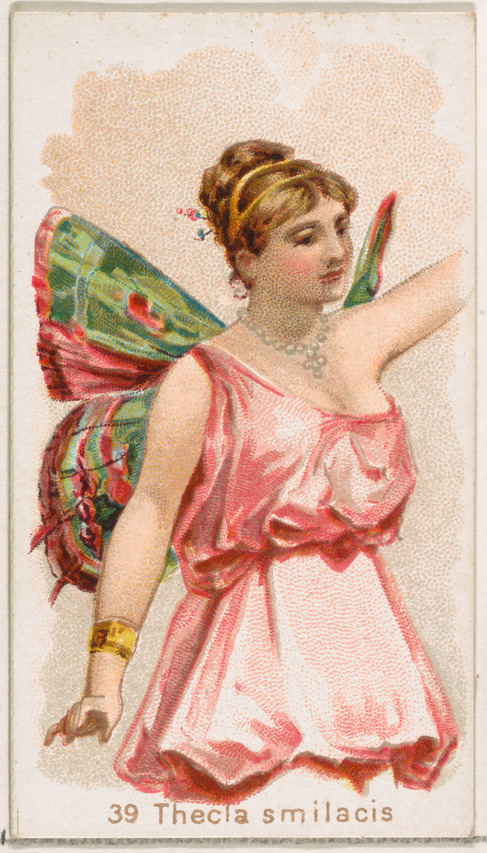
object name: print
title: Card 39, Thecla Smilacis, from the Butterflies series (N183) issued by Wm. S. Kimball & Co.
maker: william s. kimball & company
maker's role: publisher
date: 1888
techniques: color lithograph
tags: women